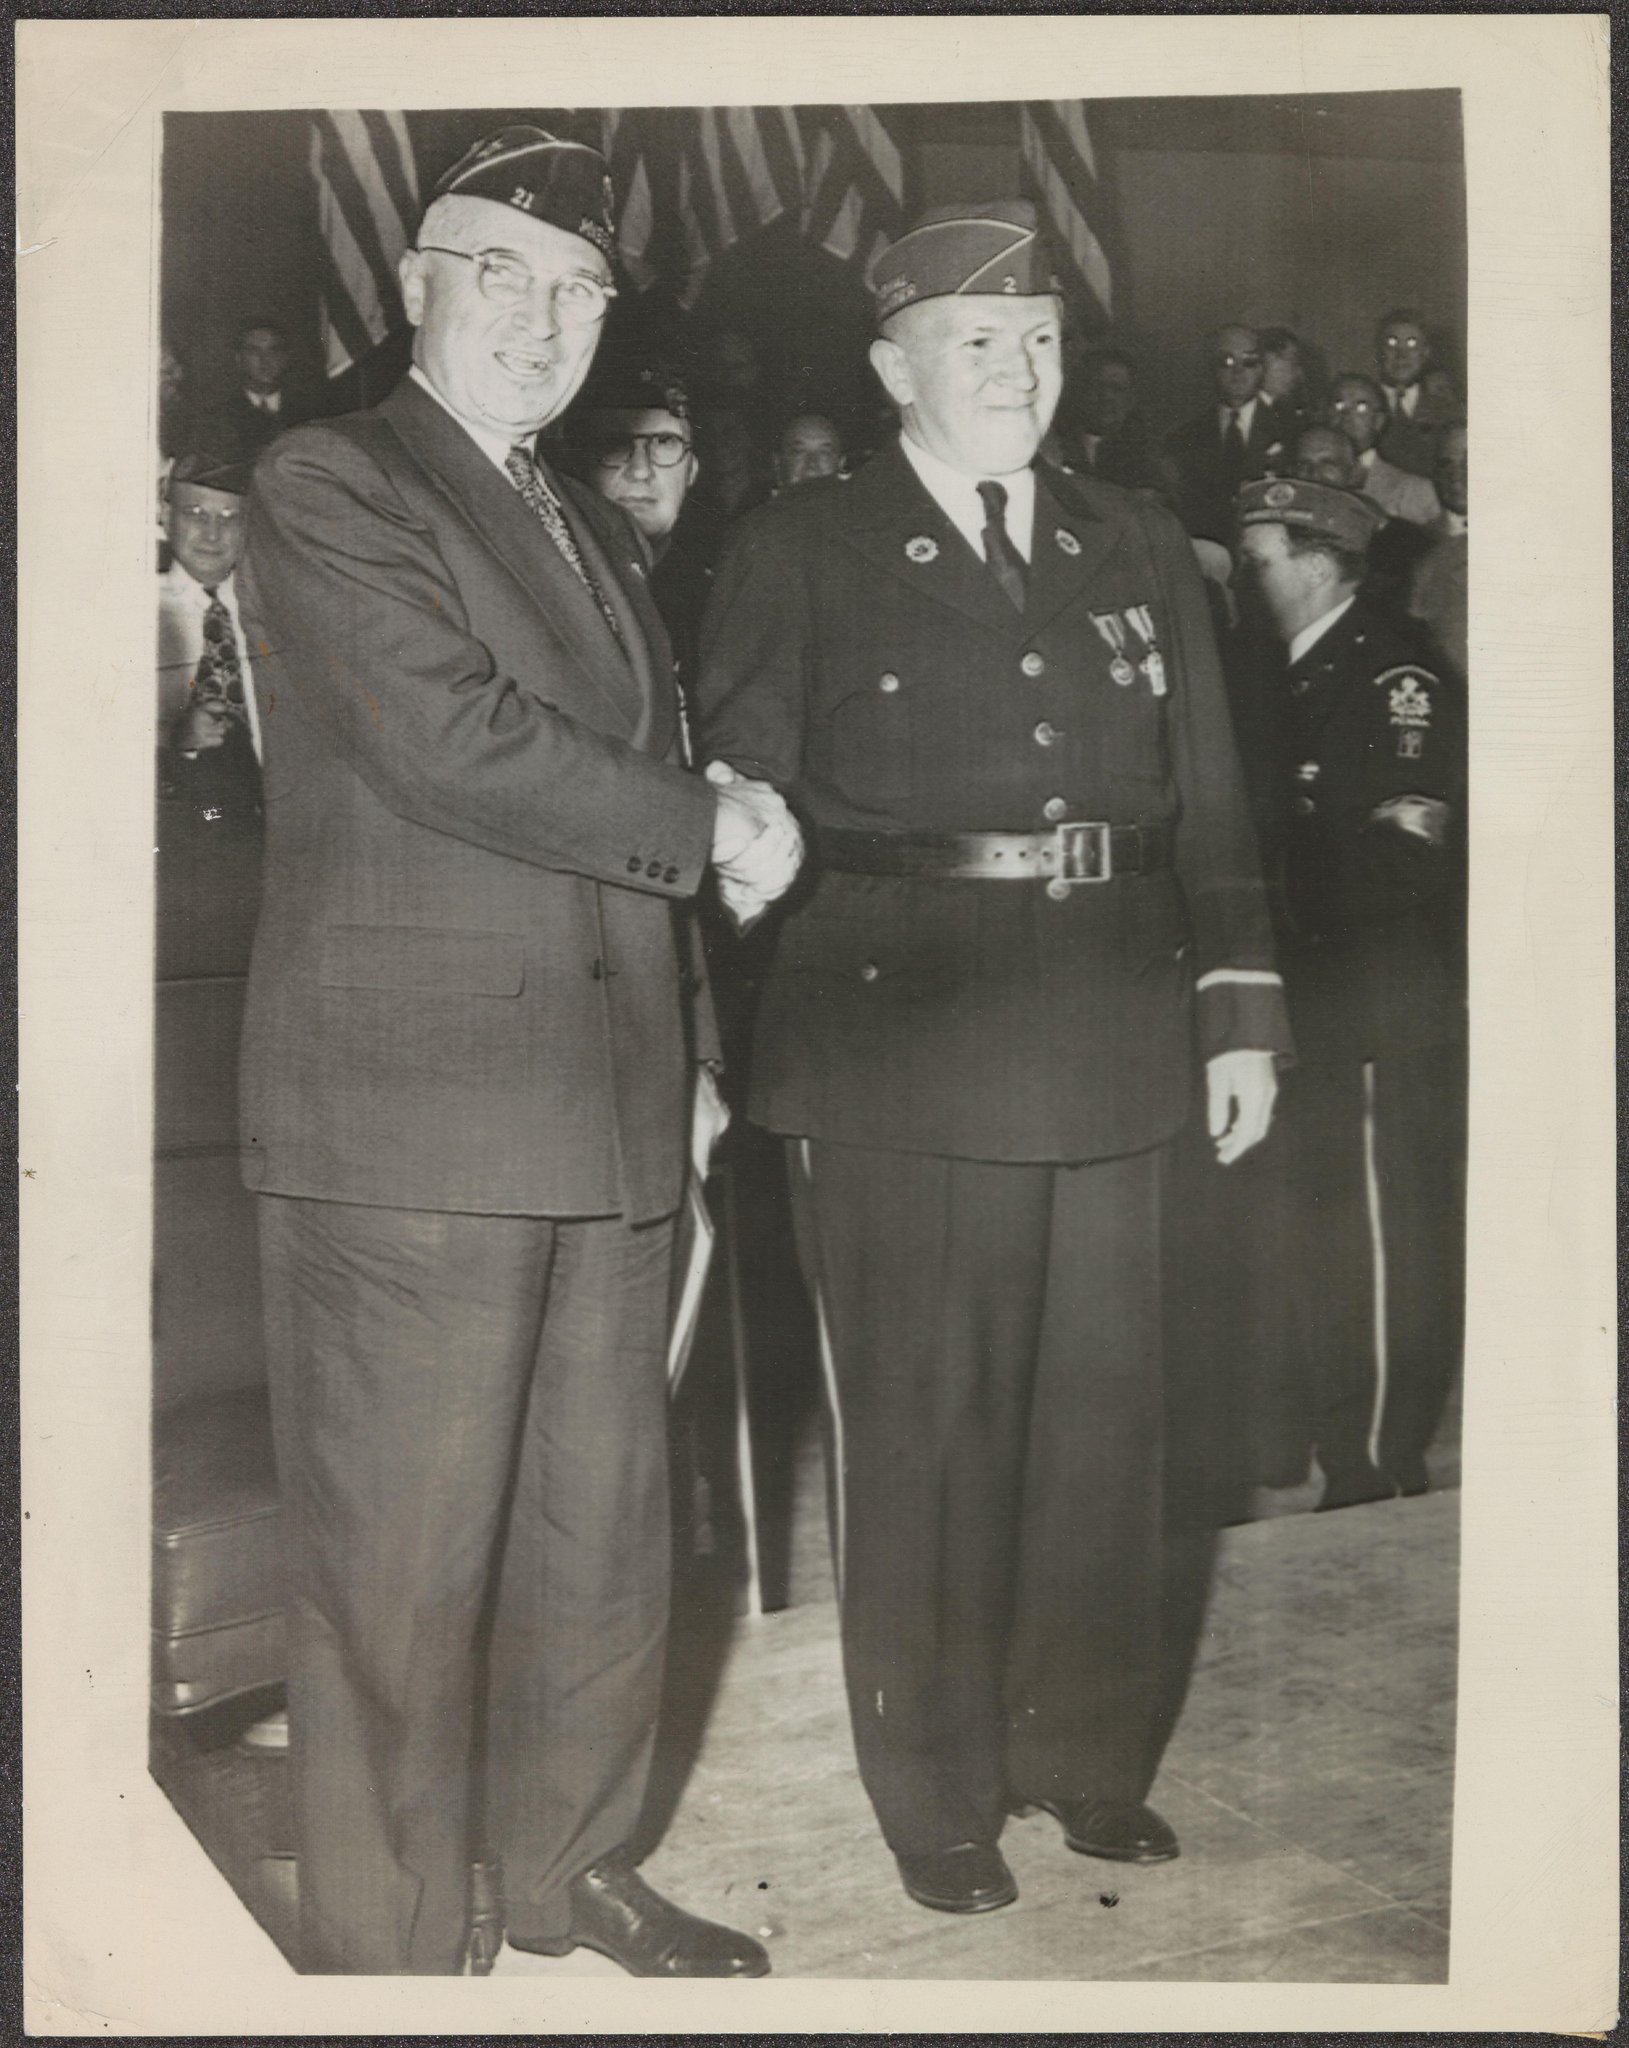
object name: photograph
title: Legionnaire Truman visits buddies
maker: irwin tress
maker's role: fotograaf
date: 1948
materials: photographic support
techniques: gelatin silver print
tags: harry s. truman, miami